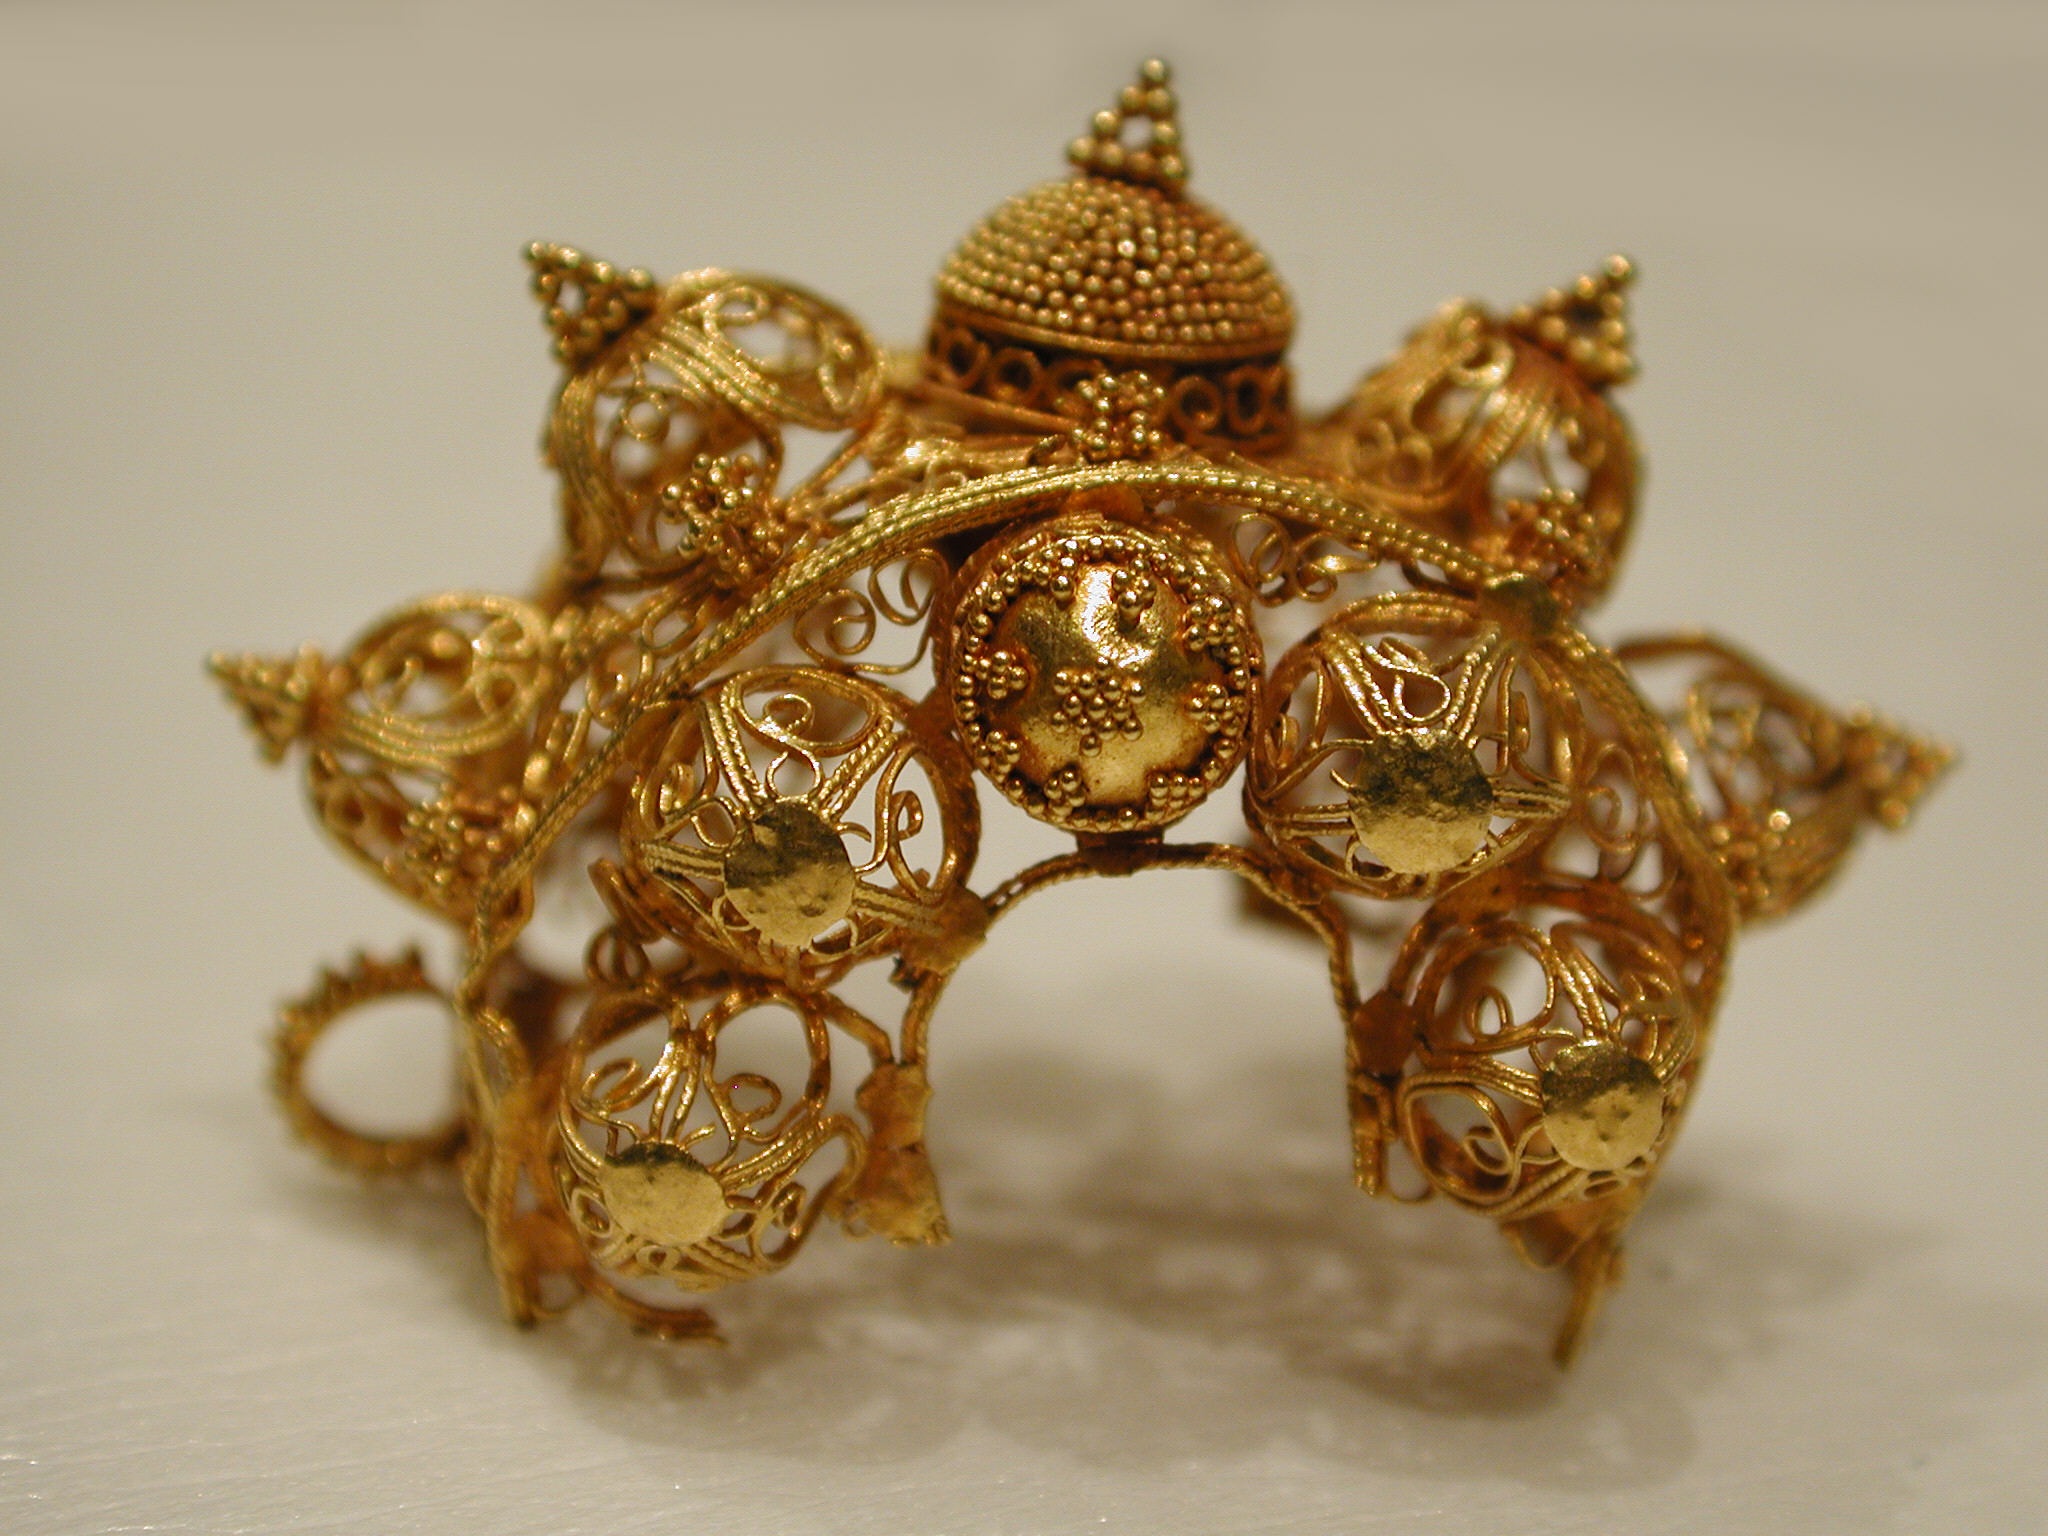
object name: earring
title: Earring, One of a Pair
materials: gold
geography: iran